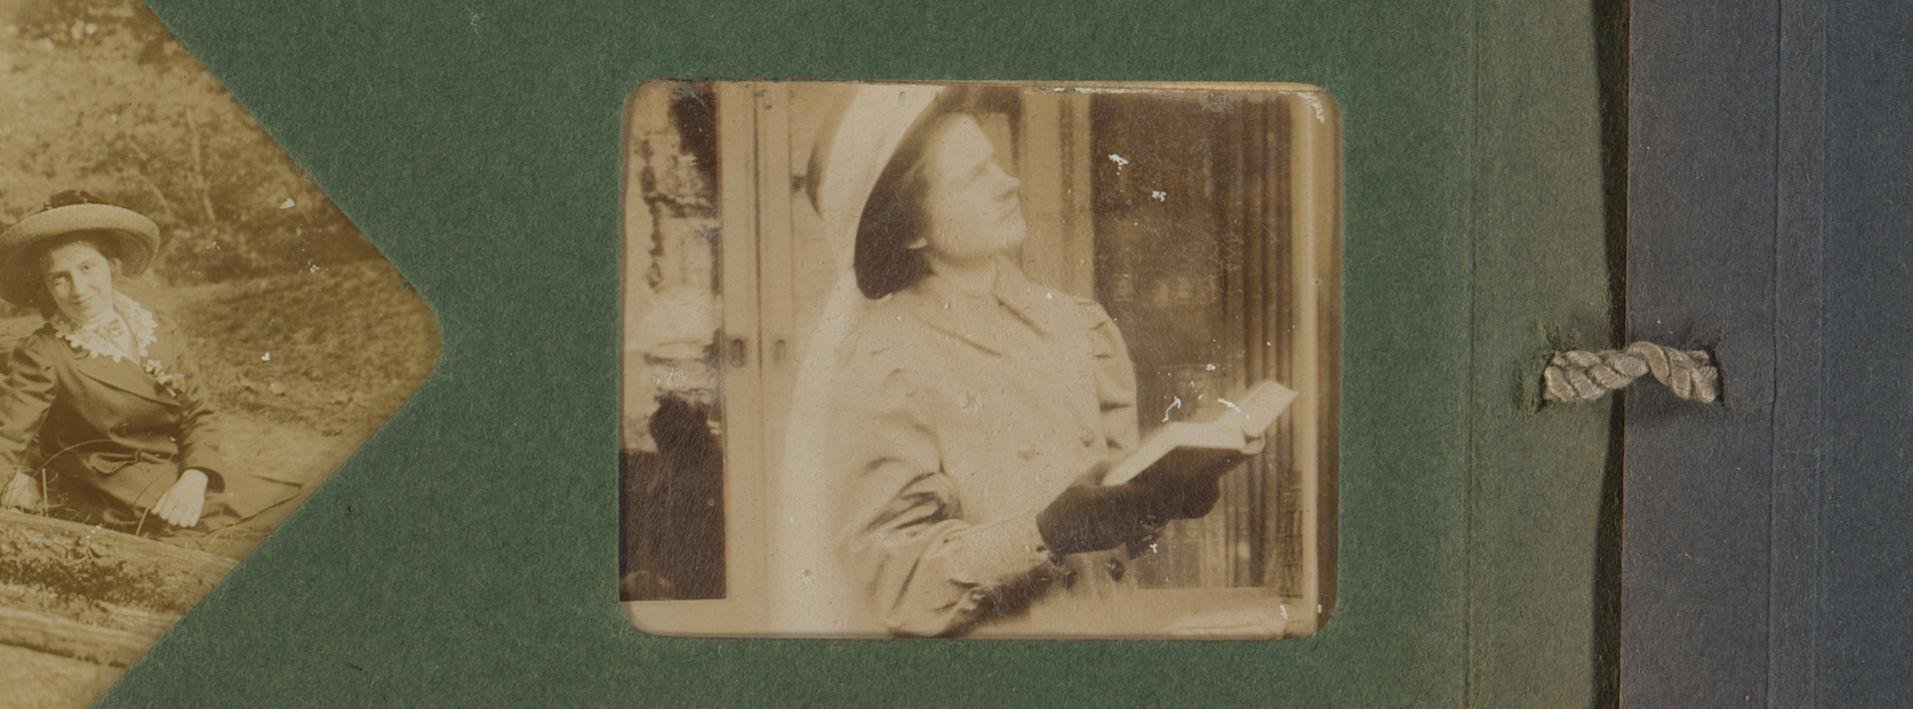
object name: photograph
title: Wiesje Merkus buiten met boek, vermoedelijk in Gelderland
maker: Anonymous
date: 1908-1912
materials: paper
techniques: gelatin silver print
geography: gelderland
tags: wiesje merkus, adolescent, young woman, maiden, gelderland